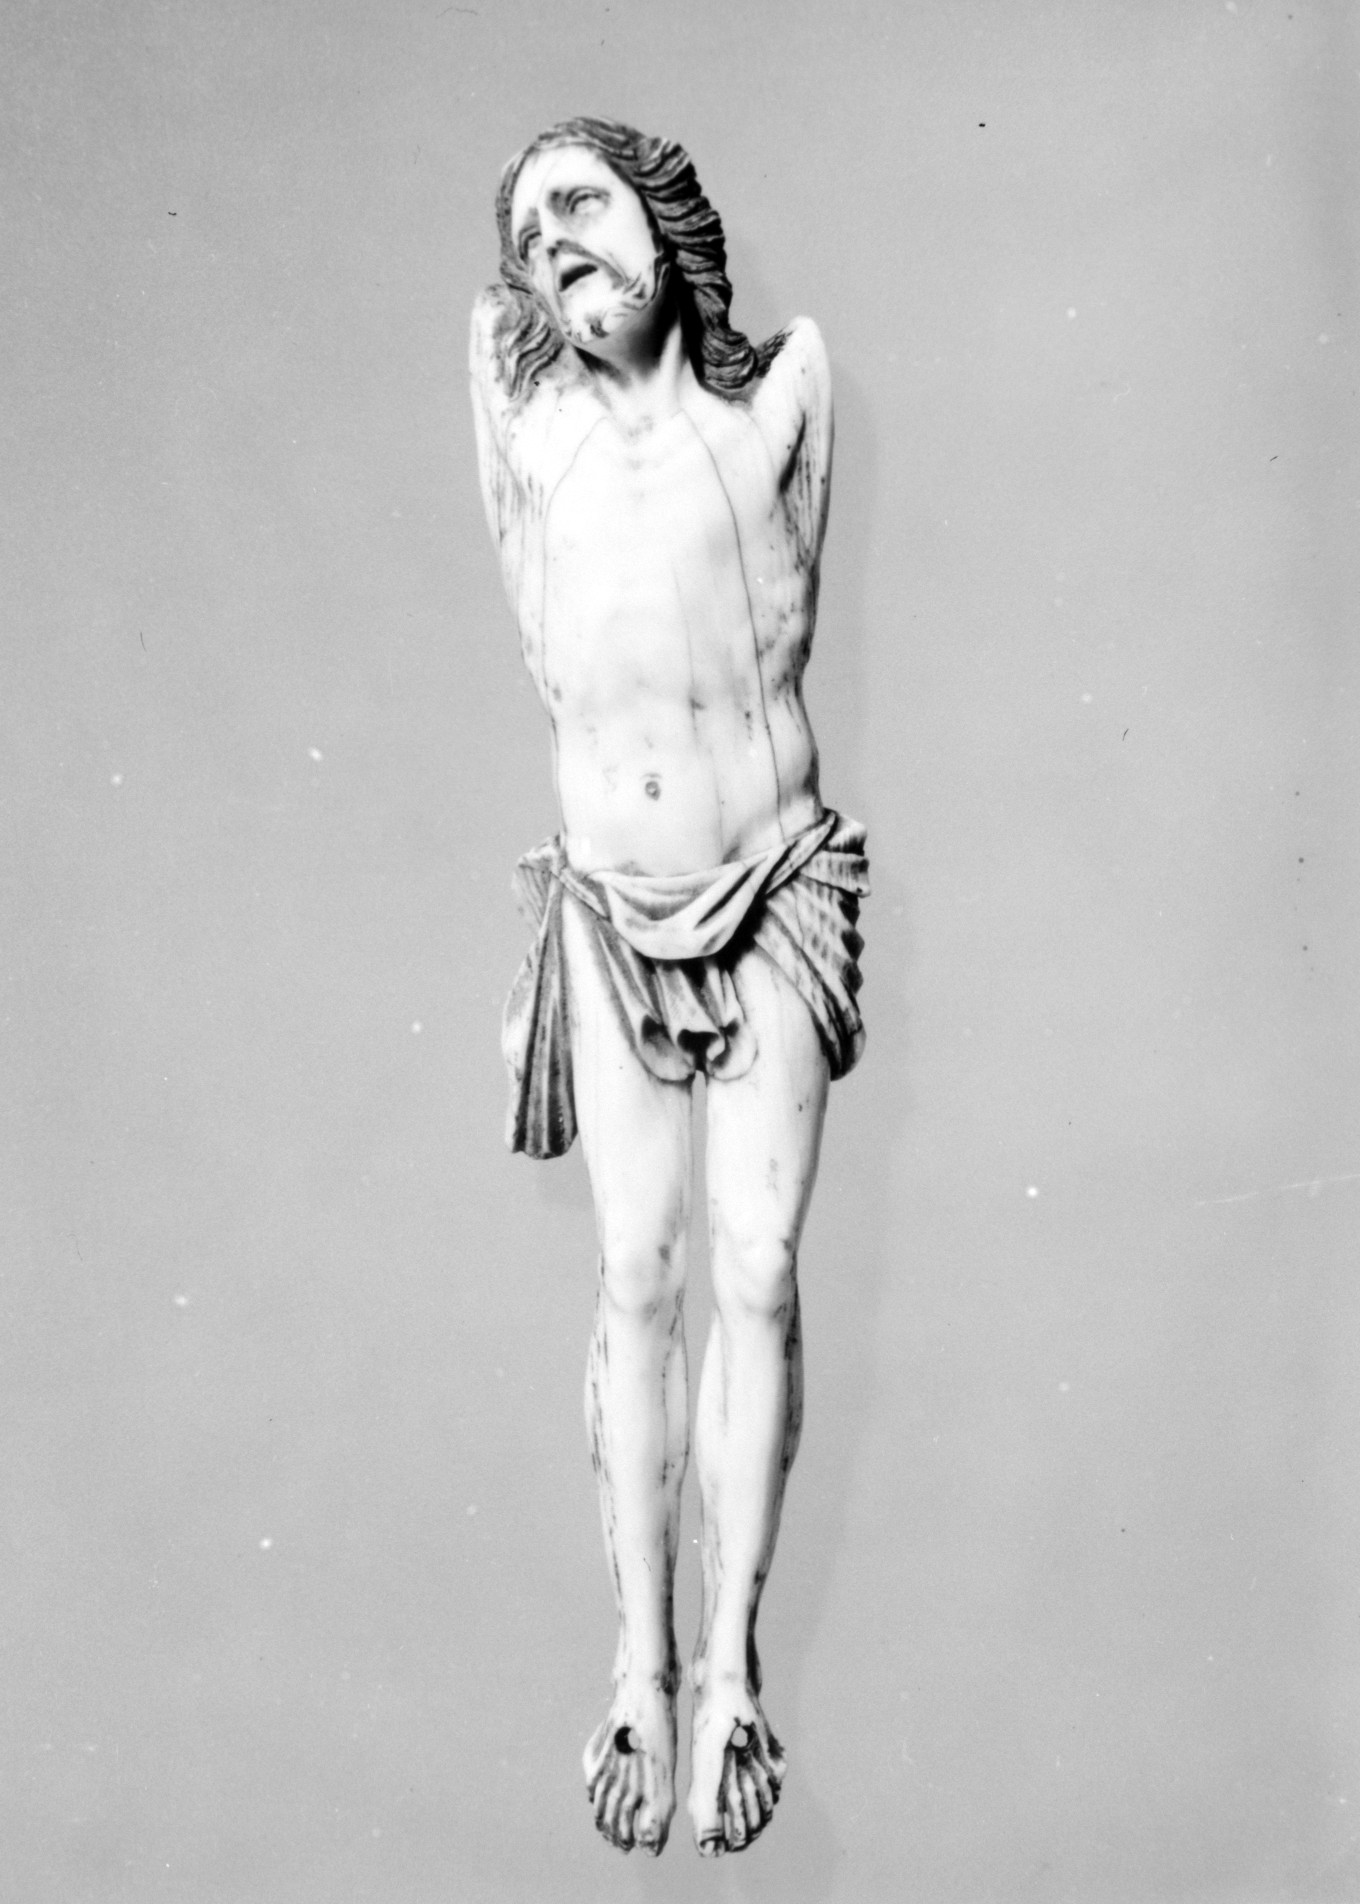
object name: corpus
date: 1601-1700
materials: ivory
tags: jesus